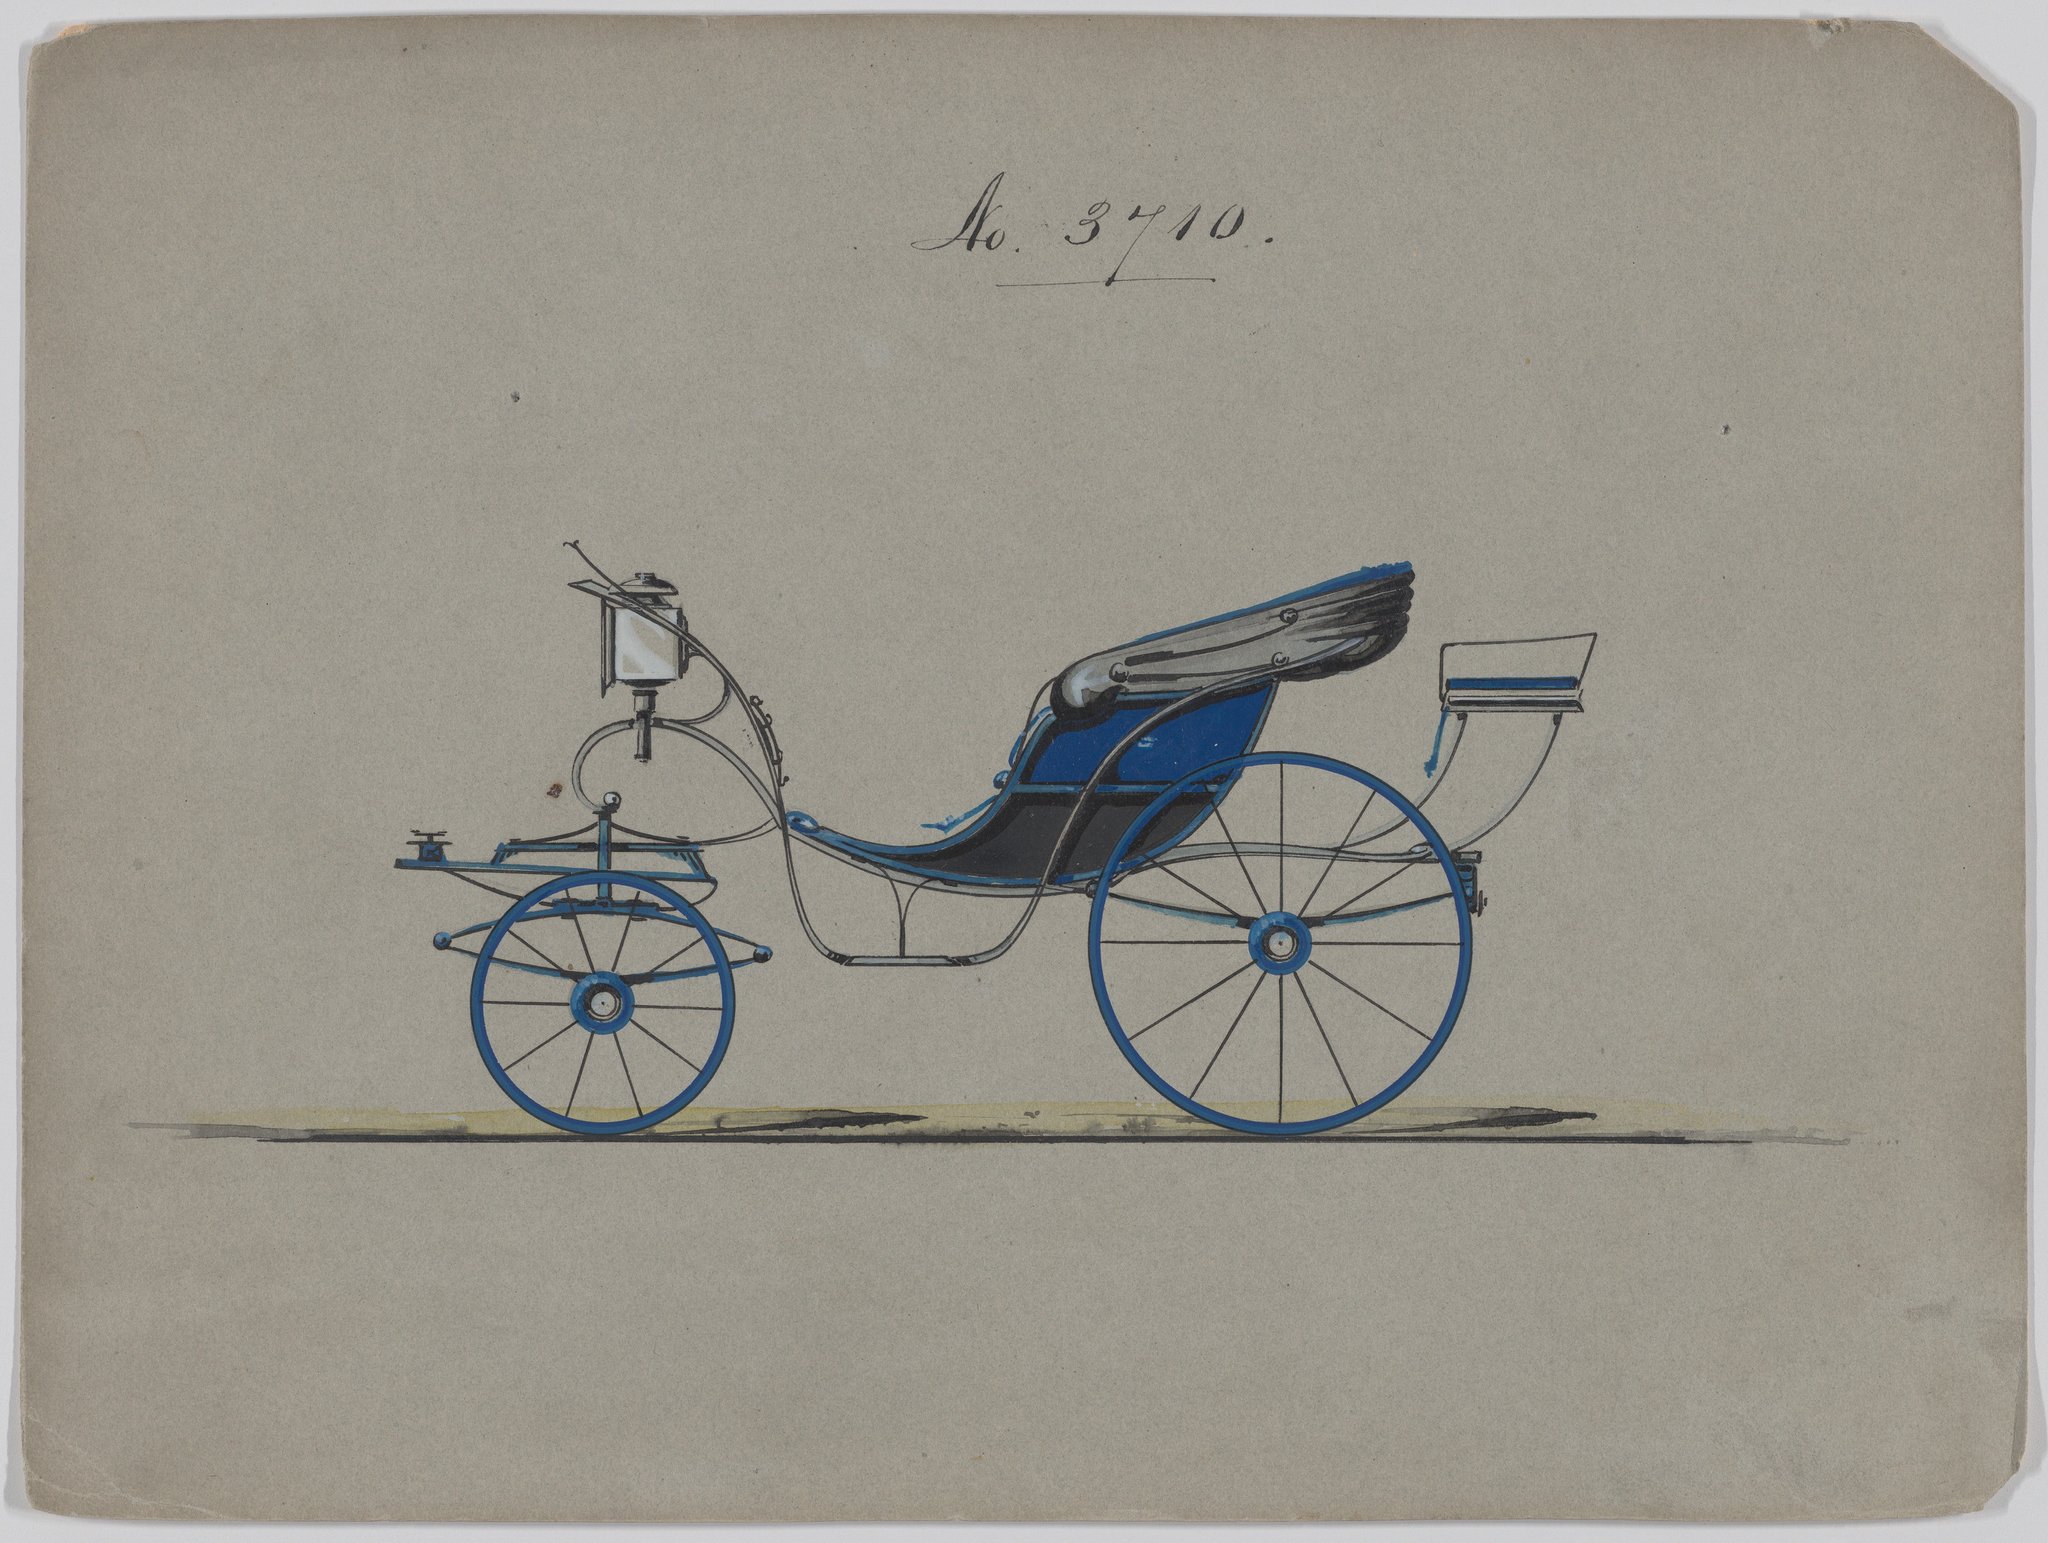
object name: drawing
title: Design for Pony Phaeton, no. 3710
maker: brewster & co.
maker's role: manufacturer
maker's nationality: american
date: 1881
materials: gouache, gum arabic, ink, watercolor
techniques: pen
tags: carriages